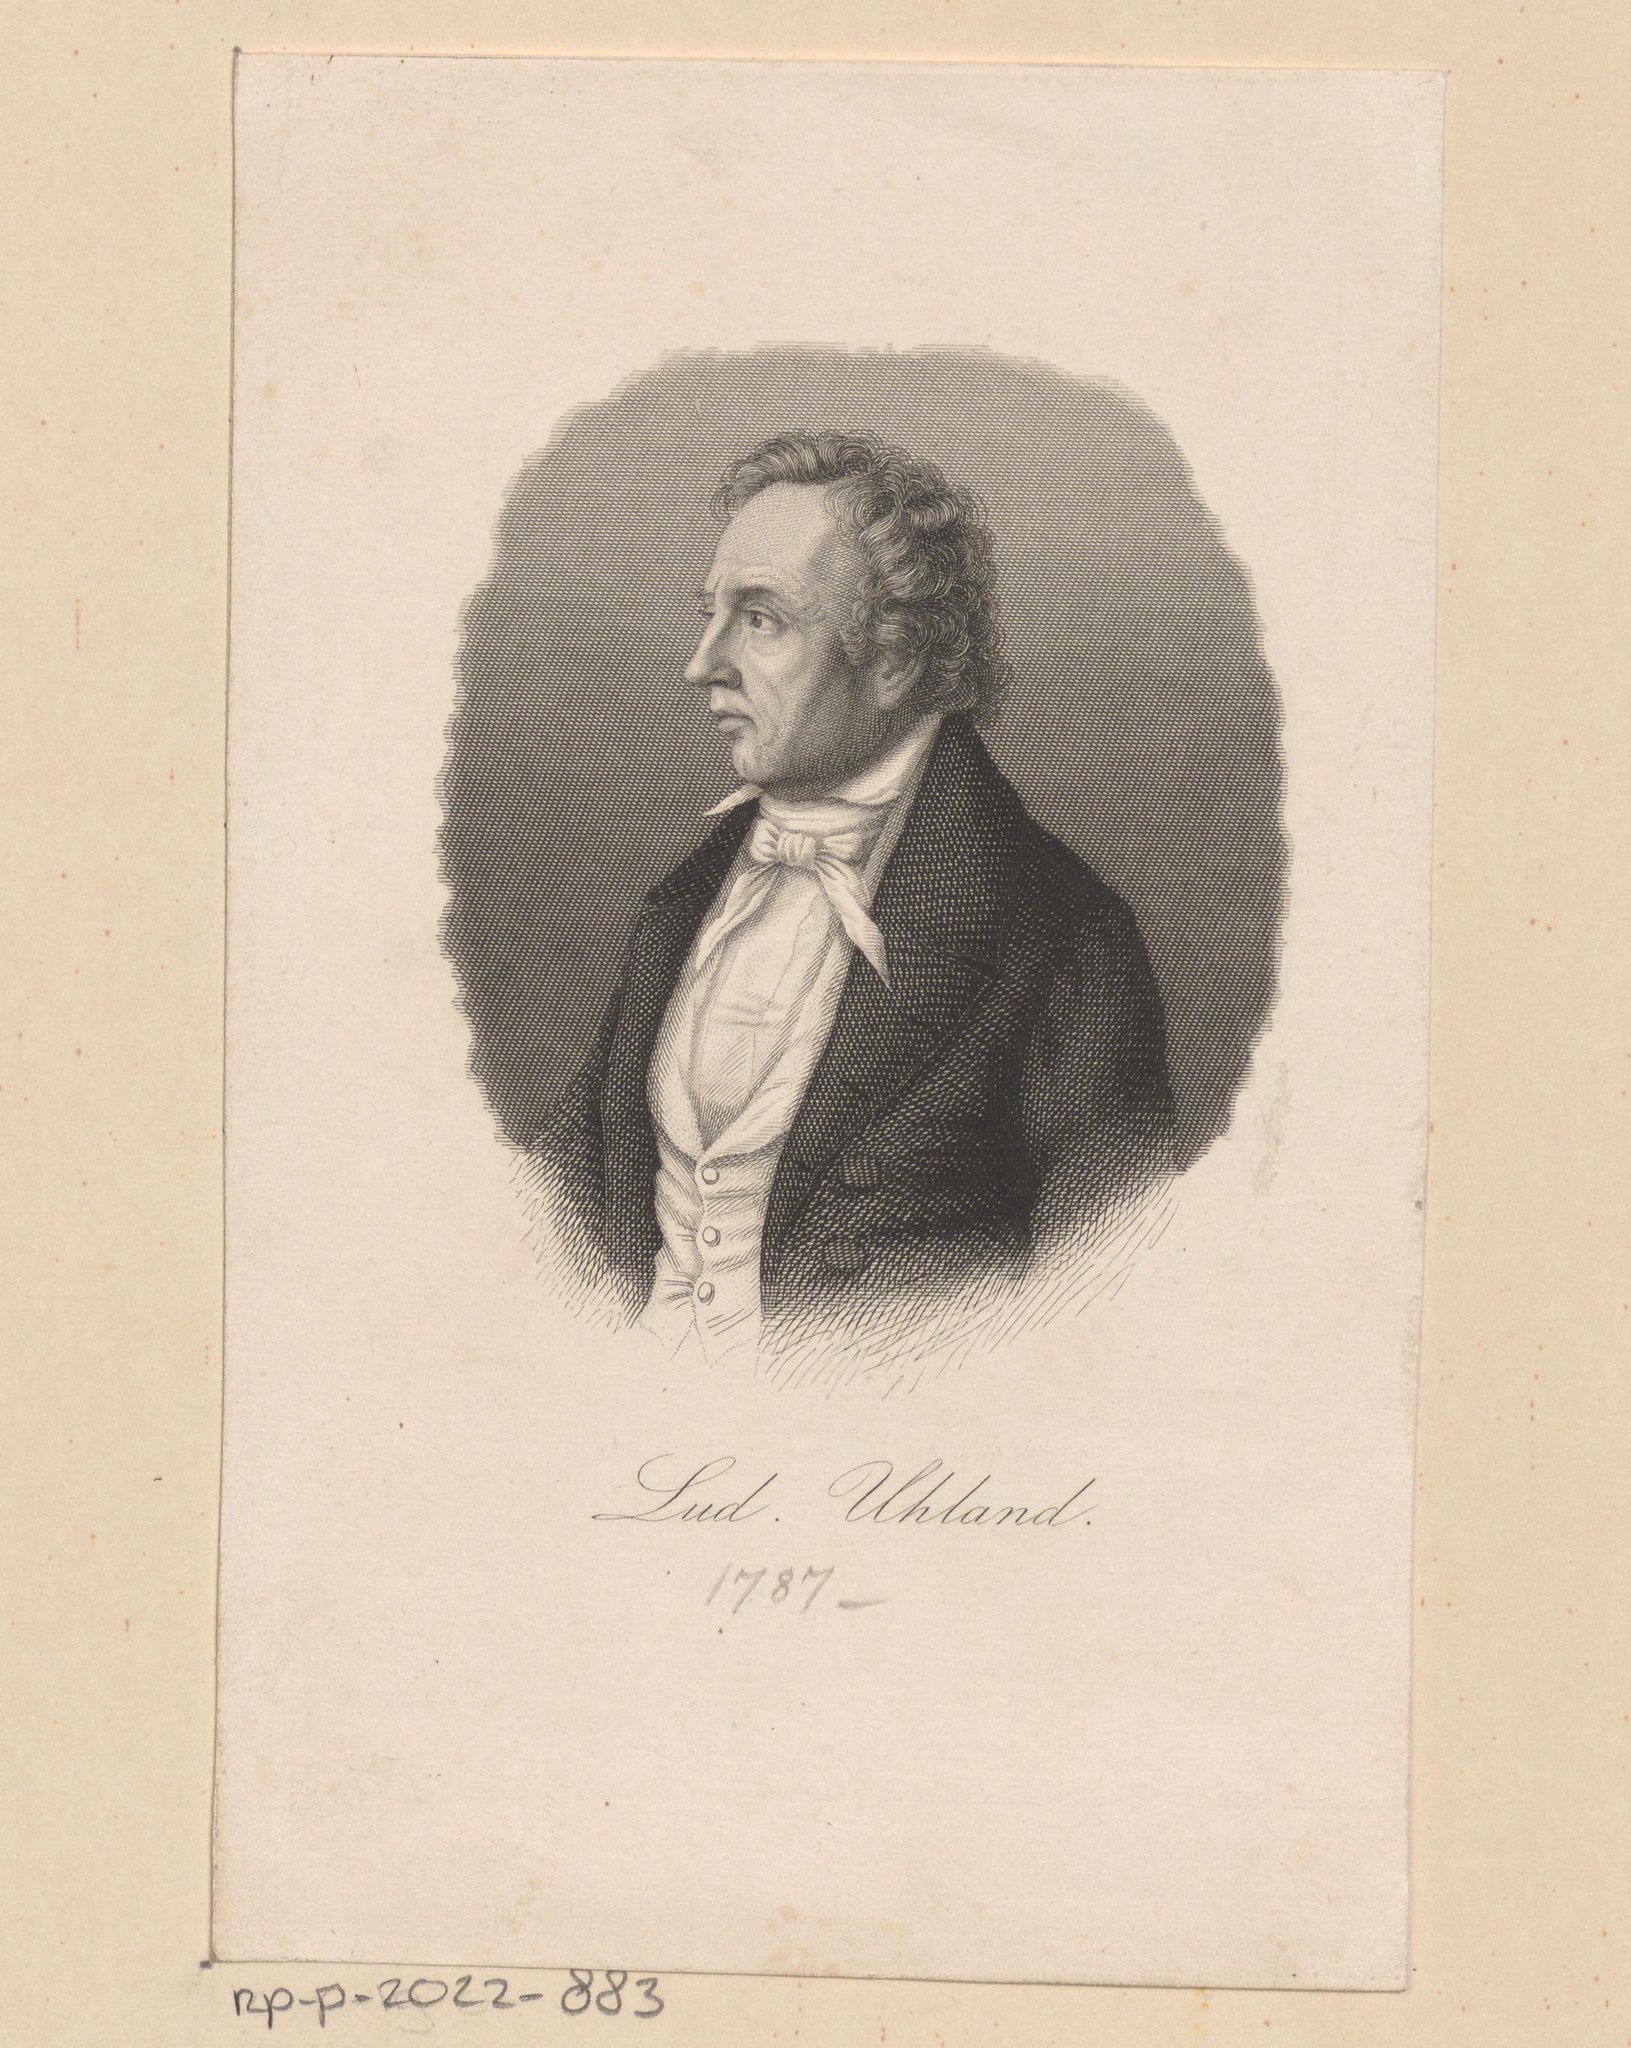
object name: print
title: Portret van Ludwig Uhland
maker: Anonymous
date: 1825-1875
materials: paper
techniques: engraving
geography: germany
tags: historical persons, portrait of a writer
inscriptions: collector's mark: Lugt 2228